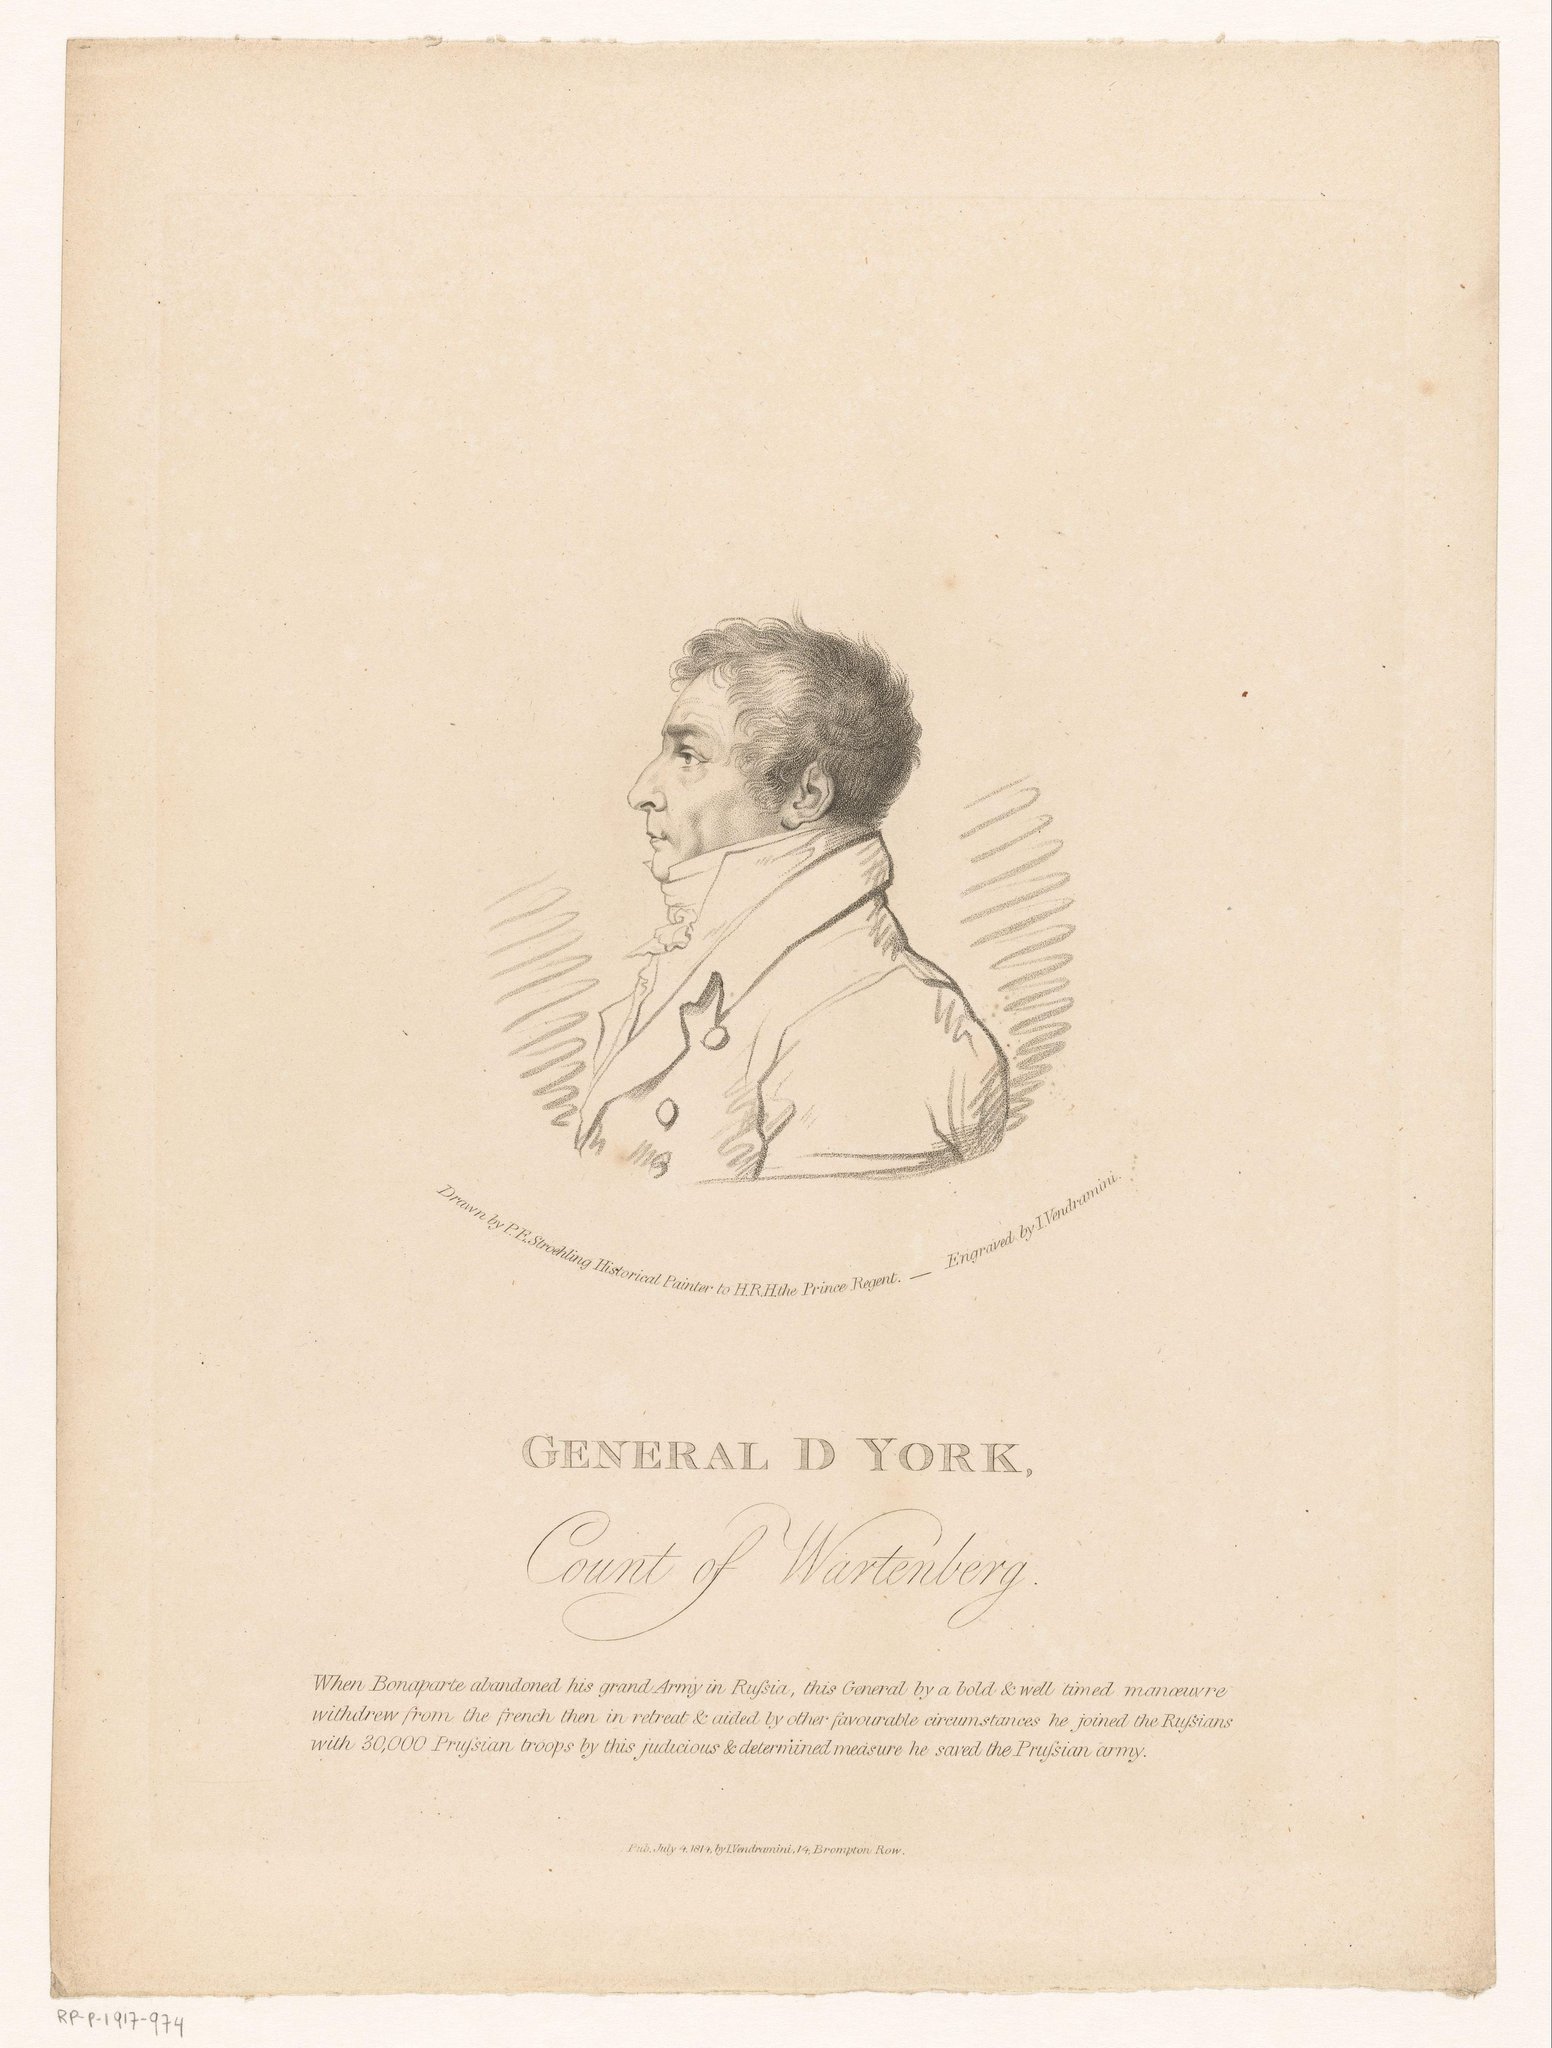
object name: print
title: Portret van militair Johann David Ludwig Yorck von Wartenburg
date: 1814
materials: paper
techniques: engraving, roulette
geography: london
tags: historical persons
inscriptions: collector's mark: Lugt 2228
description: Onder het portret drie regels Engelse tekst.